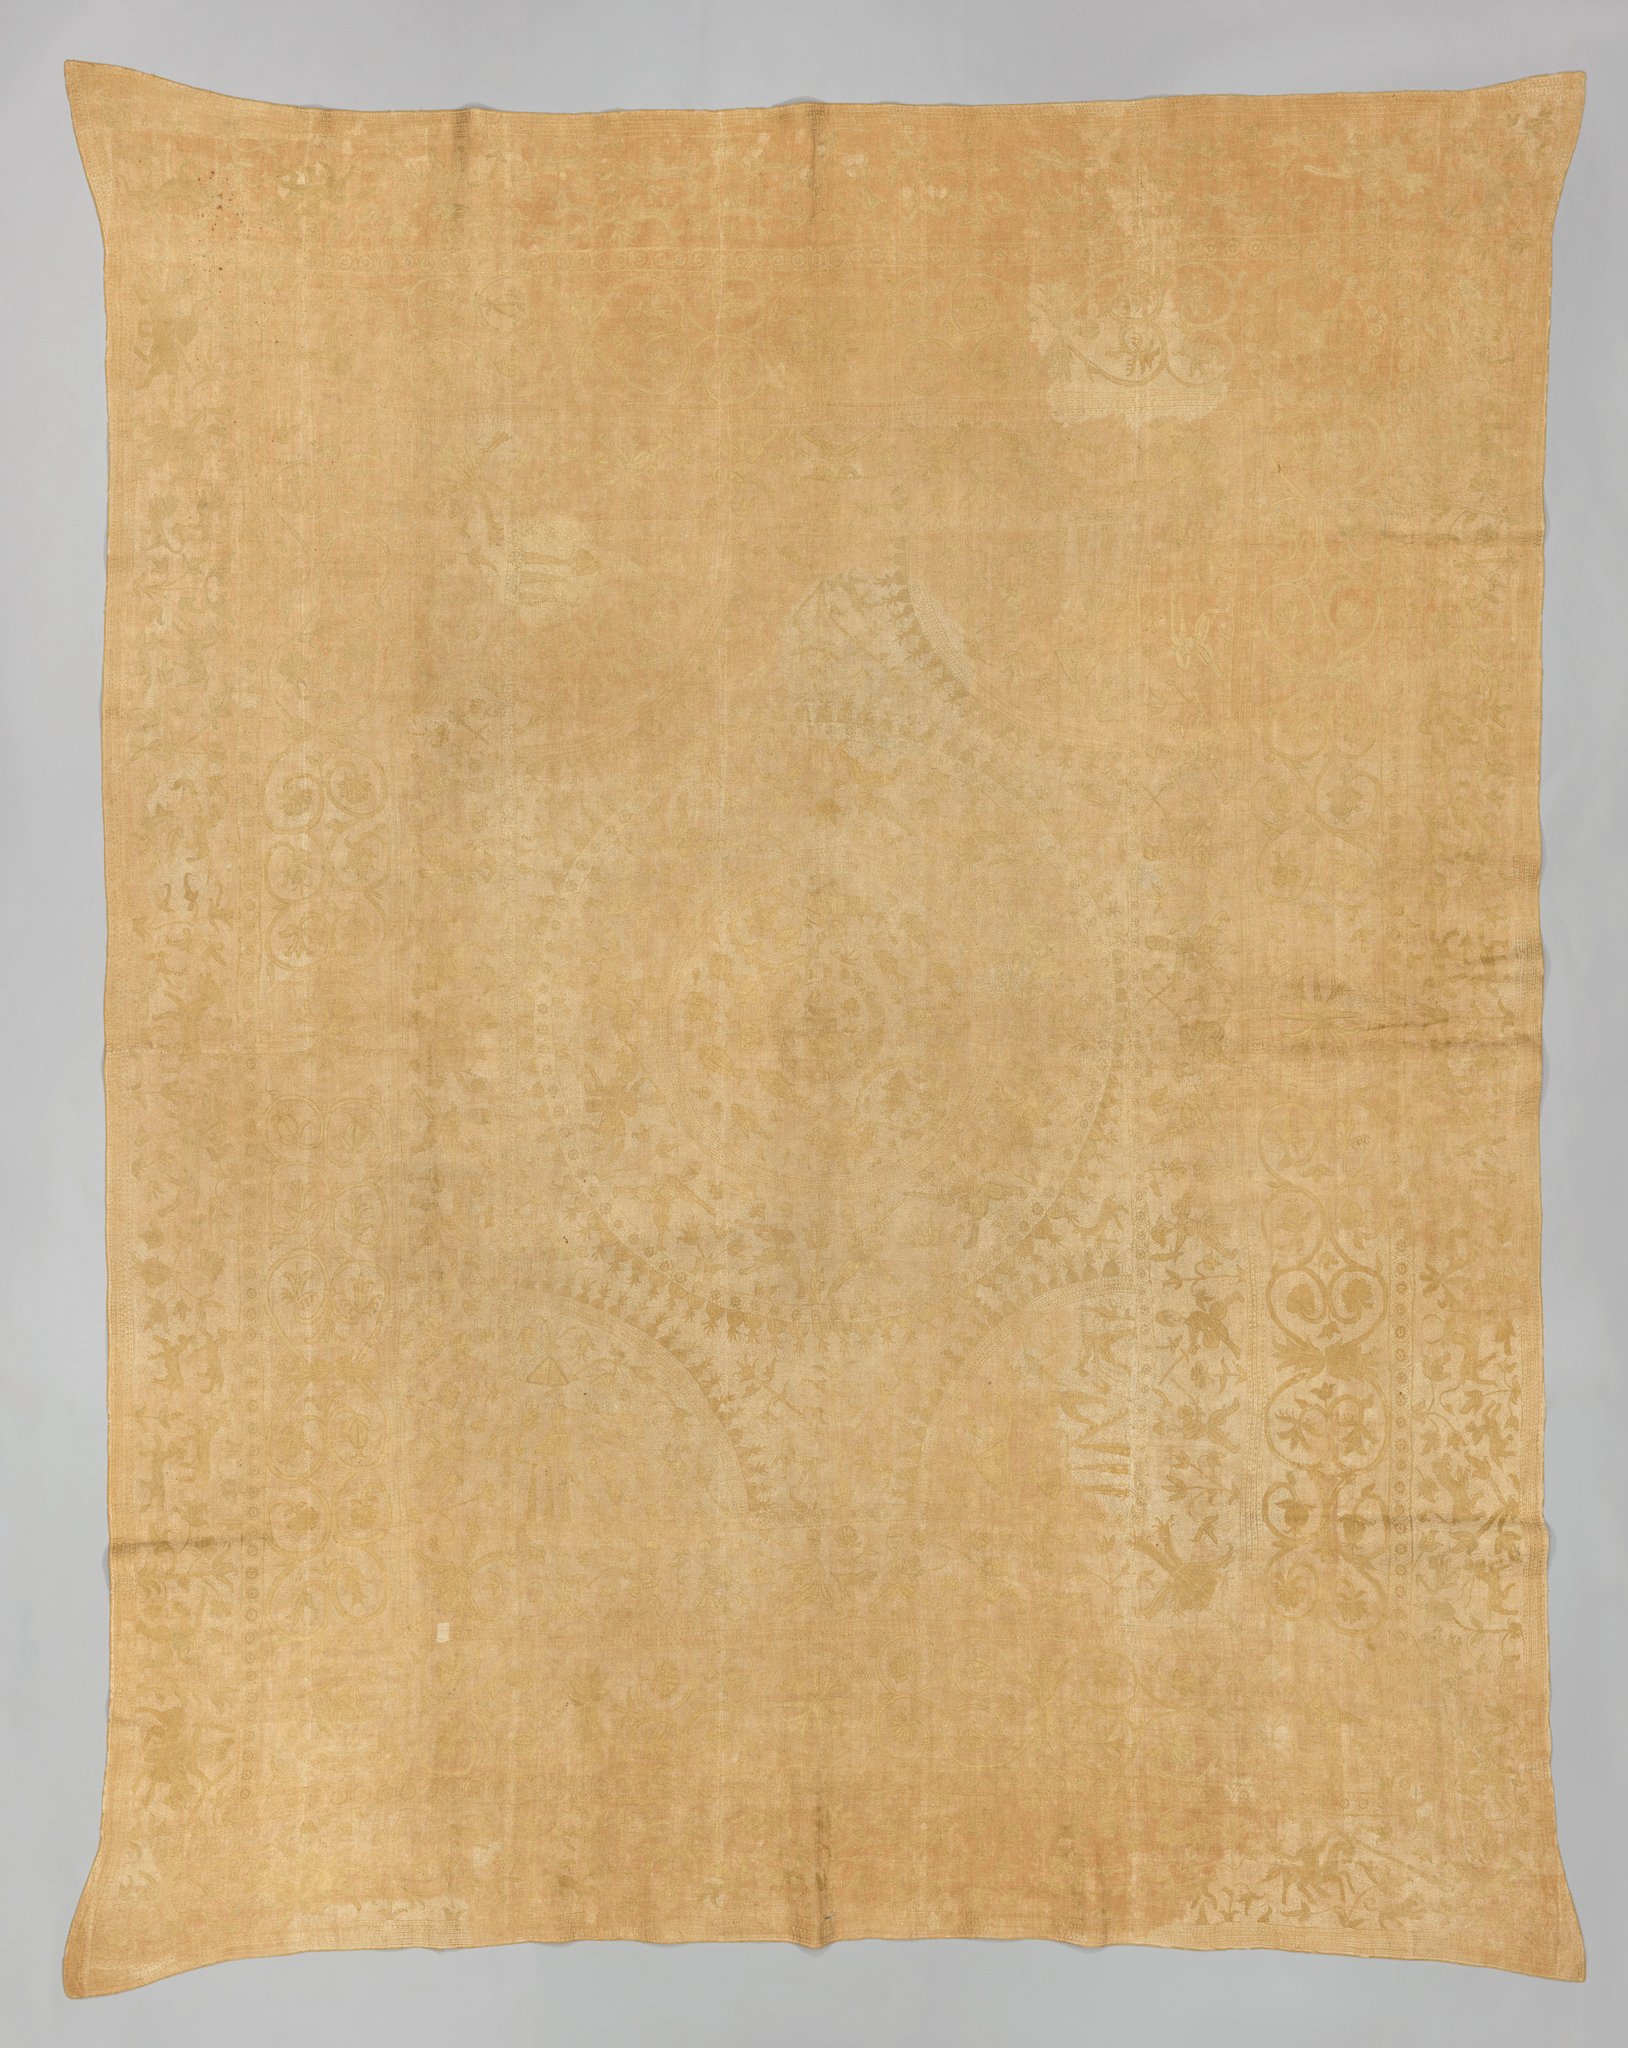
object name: textile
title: Katoenen sprei met een vis- en jachttafereel in geel borduurwerk; imitatie Bengaals borduurwerk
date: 1600-1650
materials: cotton, silk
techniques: embroidered, weave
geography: portugal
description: Katoenen sprei, gewatteerd, doorgestikt en geborduurd met gele zijde. Het patroon heeft een cirkel in het middenveld waarbinnen een oosterse vorst (tulband en een lange jas), die een bloem plukt, een vijver met mannen (in 17de eeuwse pofbroek geklede Europeanen) die op een vis gezeten met een net aan het vissen zijn en een kring van duellerende krijgers, zowel te voet en met rondas en zwaard als te paard met speer. Oosterse textiel.